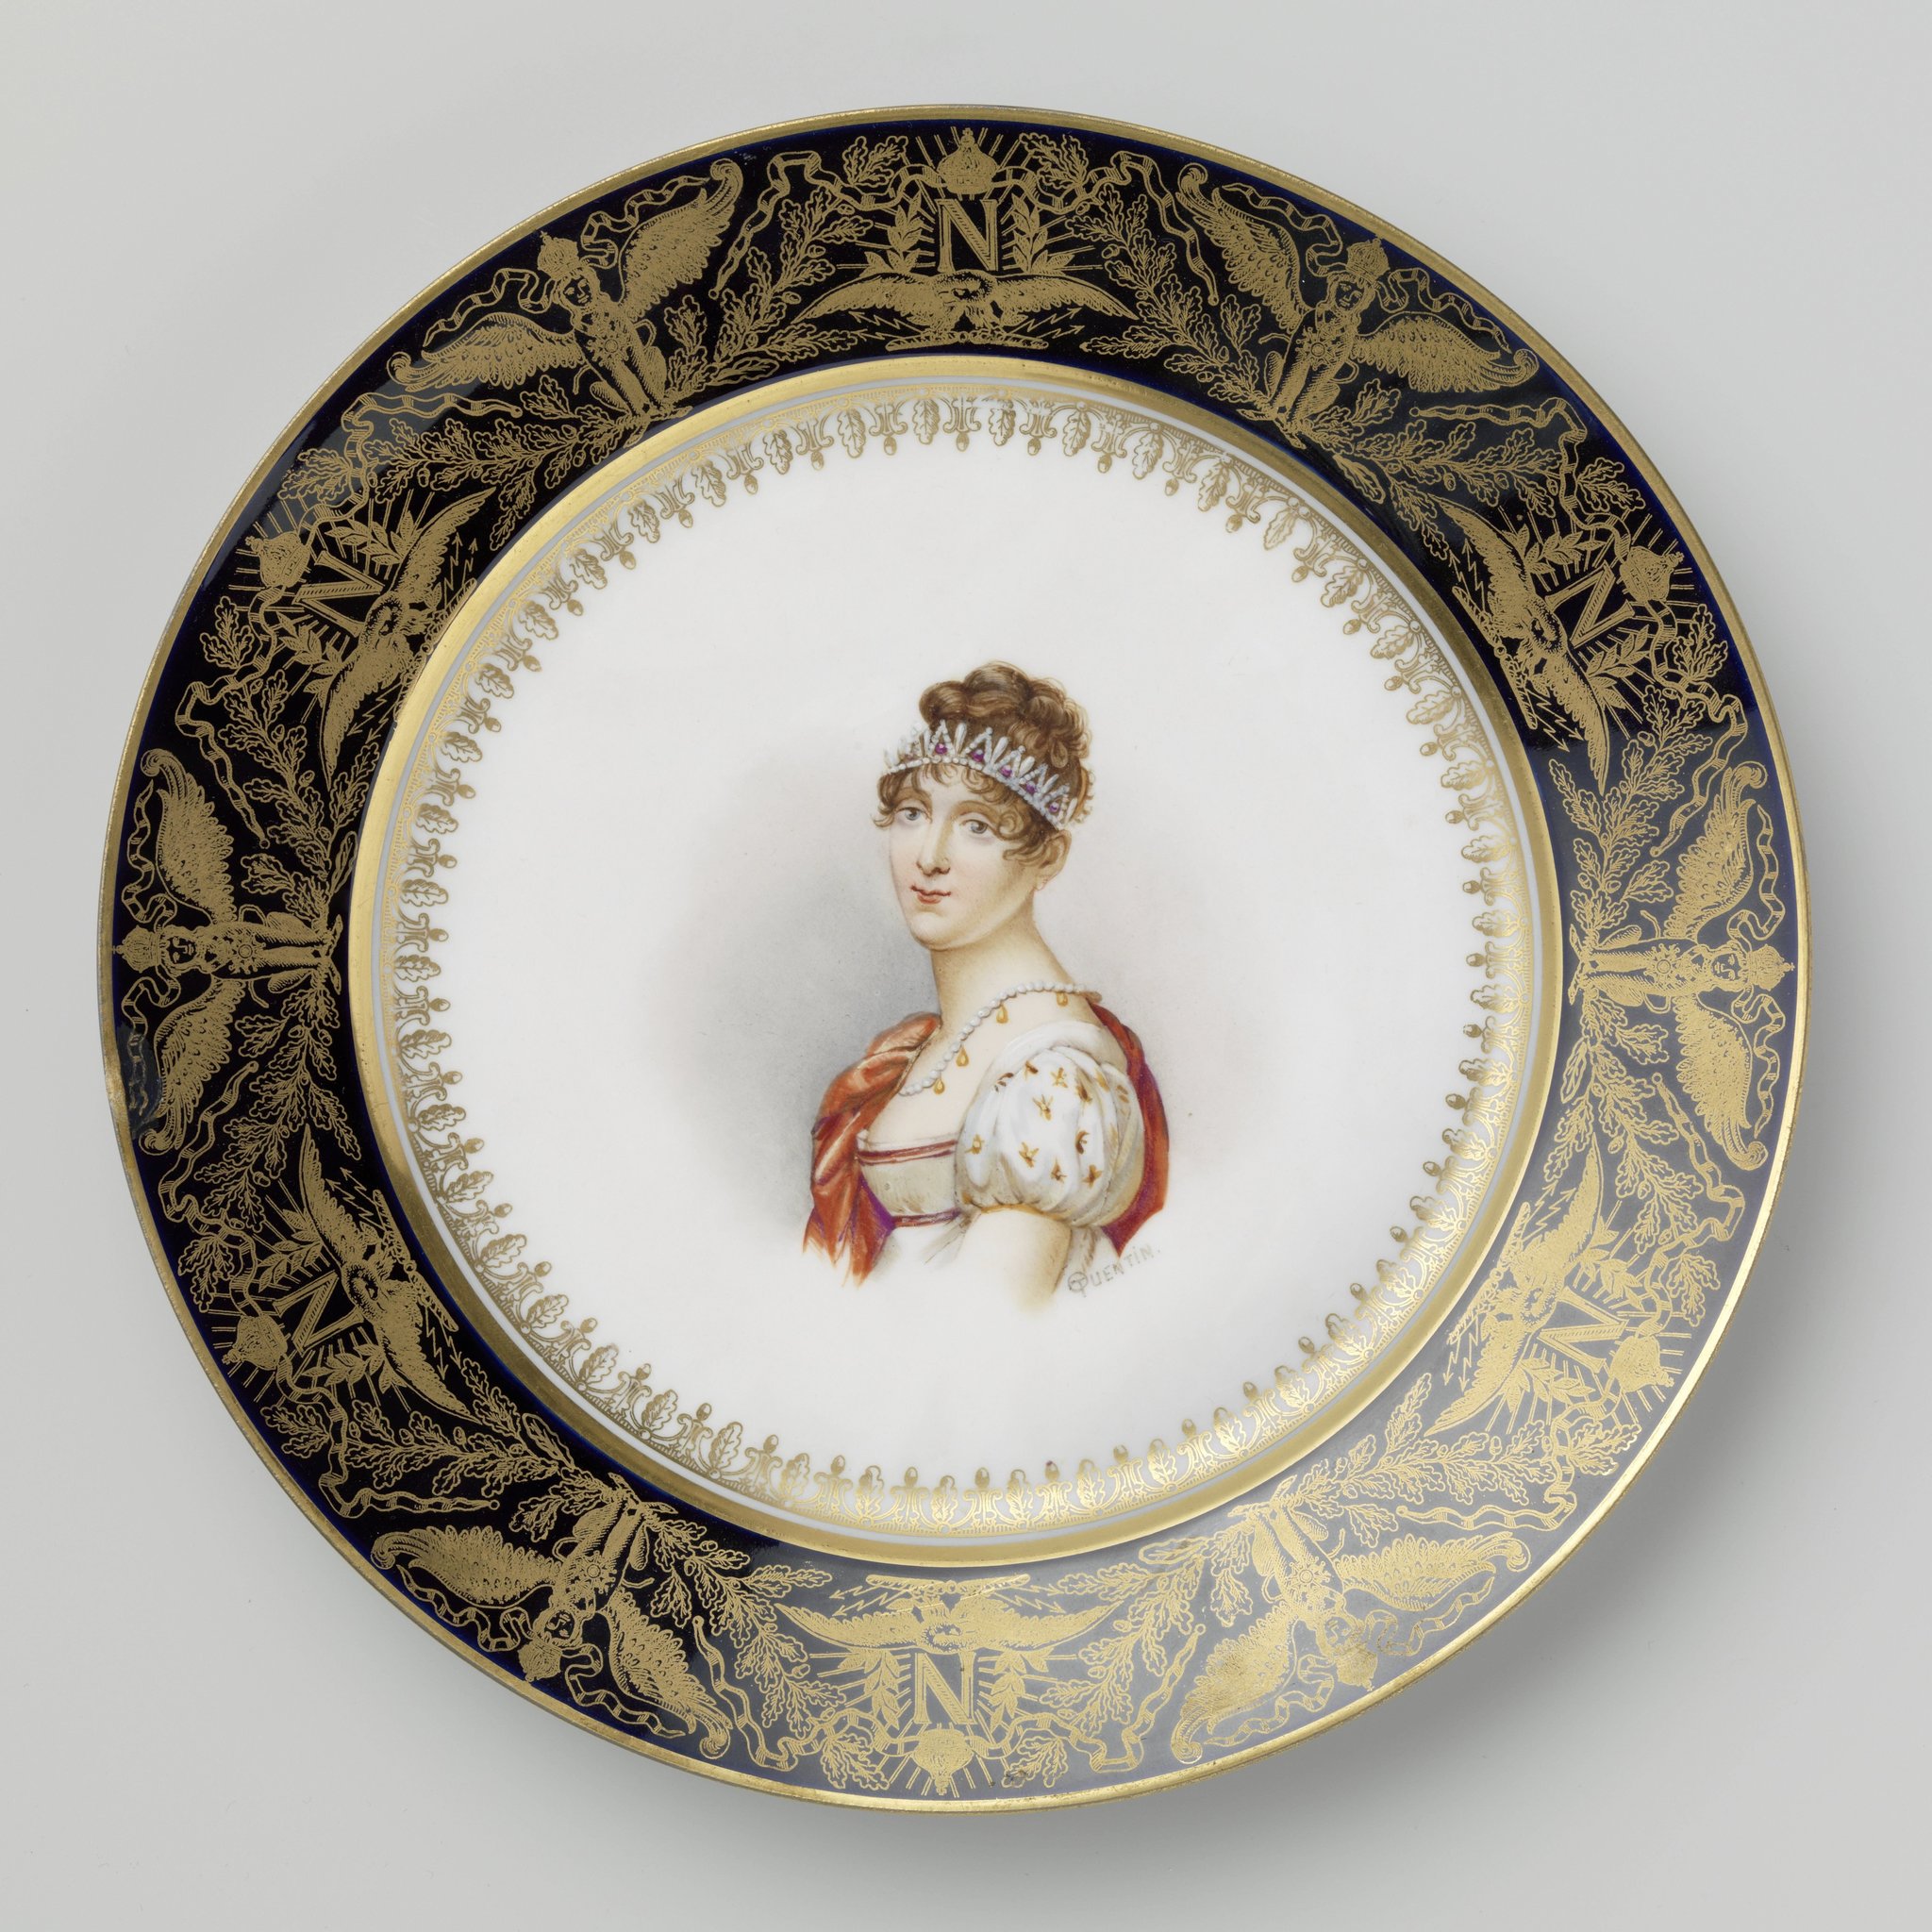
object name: plate dish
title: Plate with Hortense de Beauharnais, Queen of The Netherlands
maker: quentin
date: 1804-1809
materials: cobalt, glaze, gold, paint, porcelain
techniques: firing, gilding, turning, vitrification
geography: sèvres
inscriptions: mark: ‘LE M. IMP DE SÈVRE’, inscription: ‘REINE HORTENSE’, signature: ‘J.Quentin’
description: Bord van porselein, beschilderd in onderglazuur blauw en op het glazuur in emailkleuren en goud. Op het plat een portret van Hortense de Beauharnais (1783-1837), Koningin van Nederland. Om het portret een medaillon met bladmotieven. De rand is versierd met een decoratie in empire-stijl met de gekroonde letter N en sfinxen. Op de buitenwand en onderzijde lichte profielen. Het portret is gesigneerd met J. Quentin. Gemerkt op de onderzijde met 'LE M. IMP DE SÈVRE' en het opschrift 'REINE HORTENSE'.